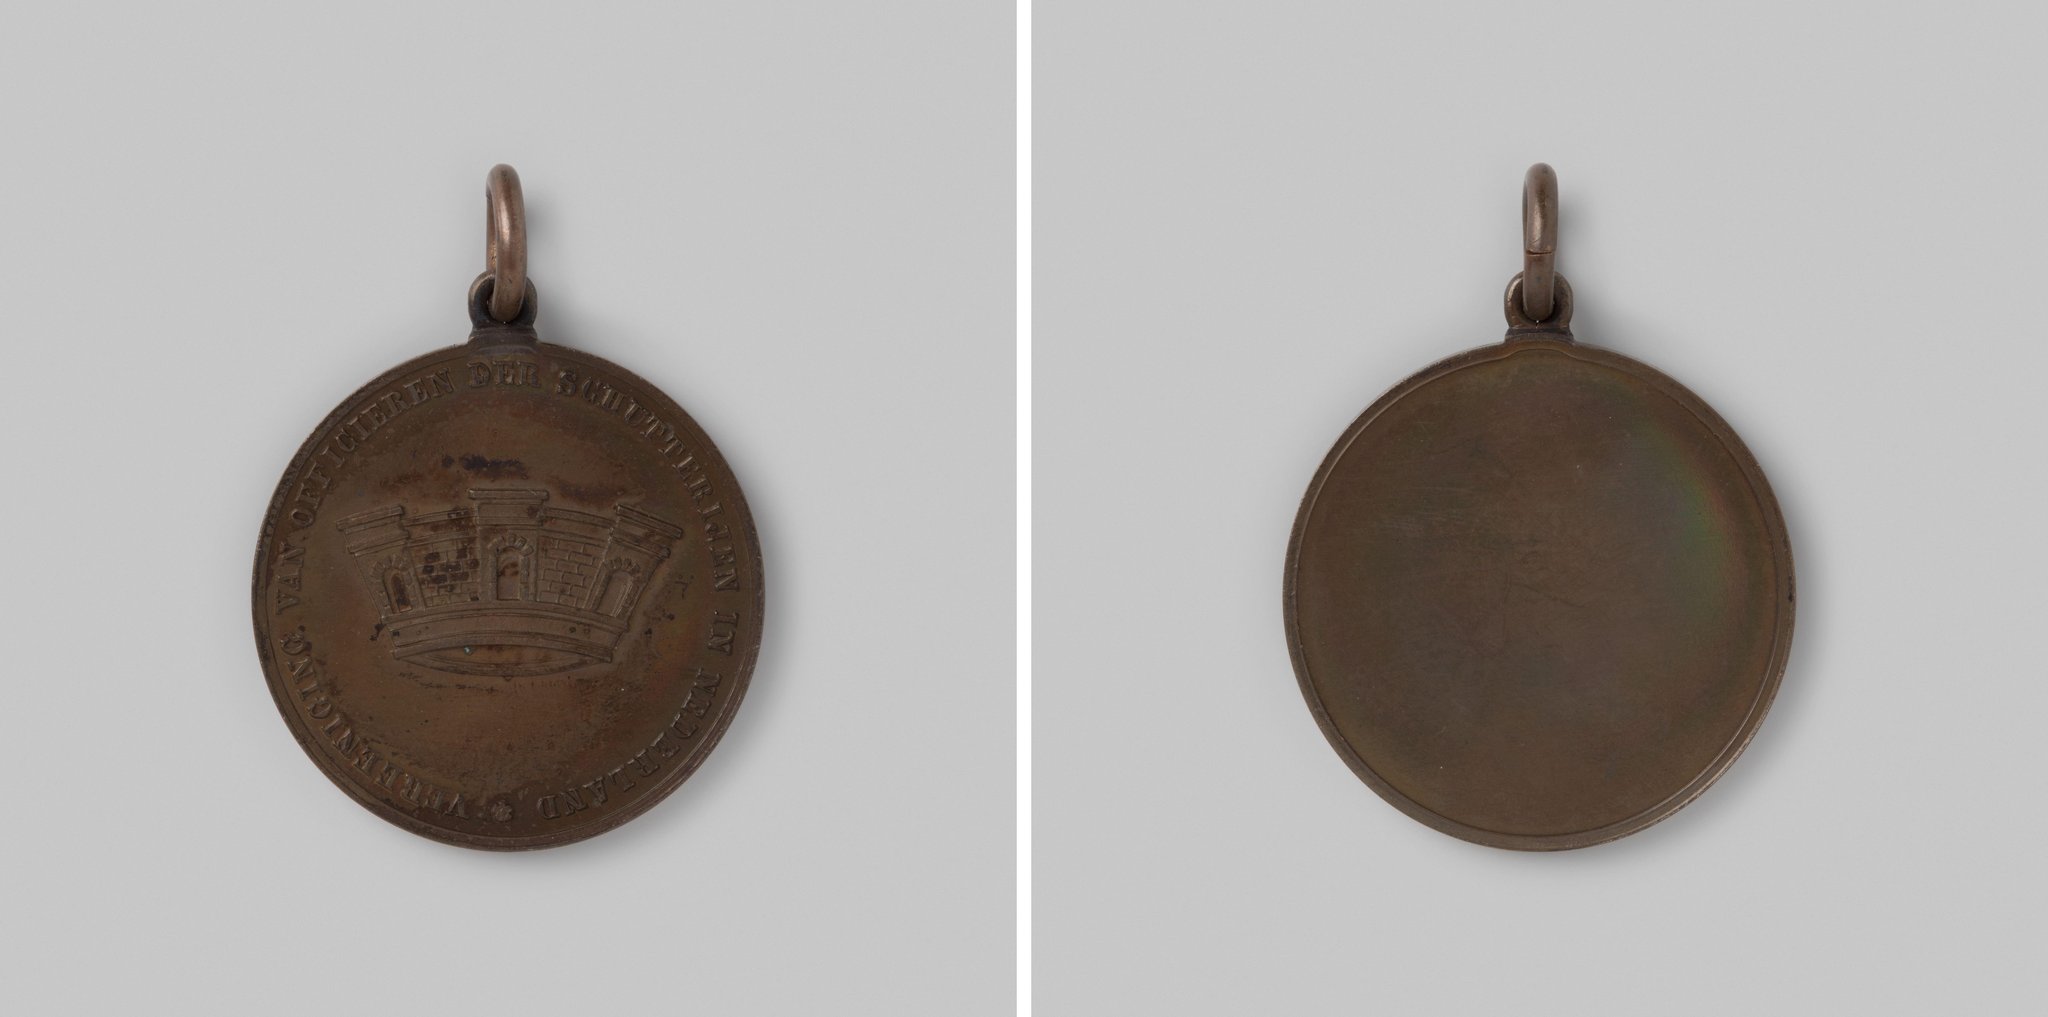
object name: draagpenning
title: Draagpenning van de Vereeniging van Officieren der Schutterijen in Nederland 1871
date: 1871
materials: bronze, silver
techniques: striking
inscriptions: circumscription: ‘VEREENIGING VAN OFFICIEREN DER SCHUTTERIJEN IN NEDERLAND’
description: Bronzen penning met oog en draagring, op de voorzijde een muurkroon met omschrift, de keerzijde blanco.